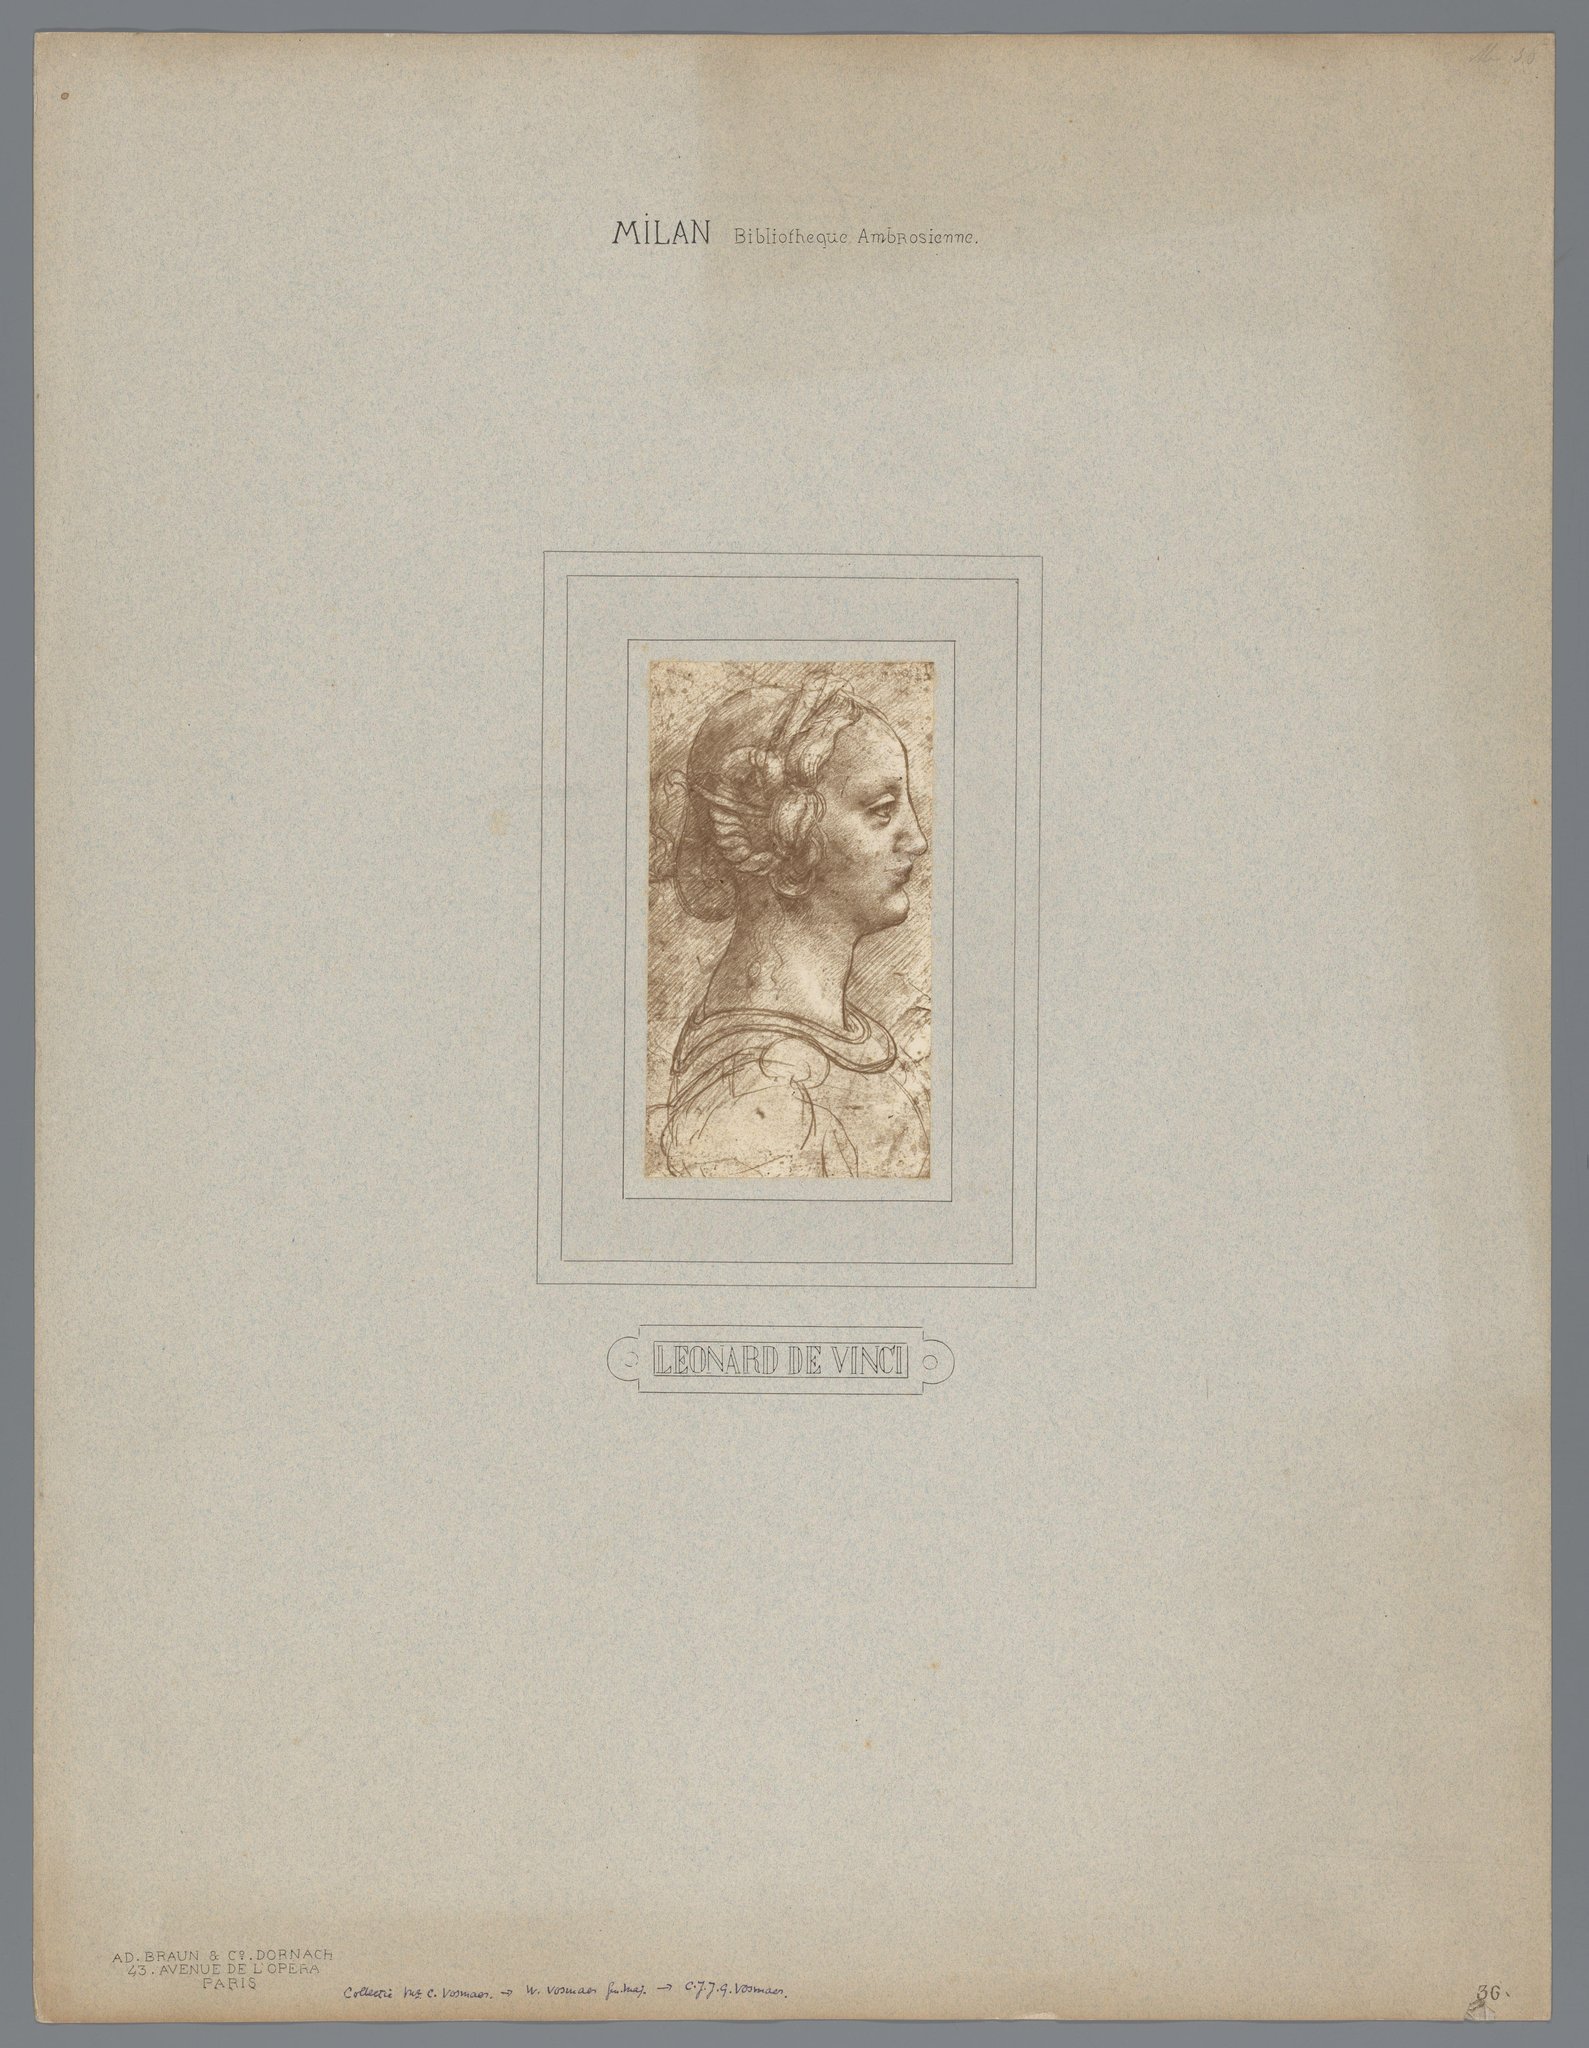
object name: photograph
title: Fotoreproductie van een tekening van Leonardo da Vinci (portret van een vrouw)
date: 1880-1900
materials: cardboard, paper, photographic support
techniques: carbon print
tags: artist, leonardo da vinci